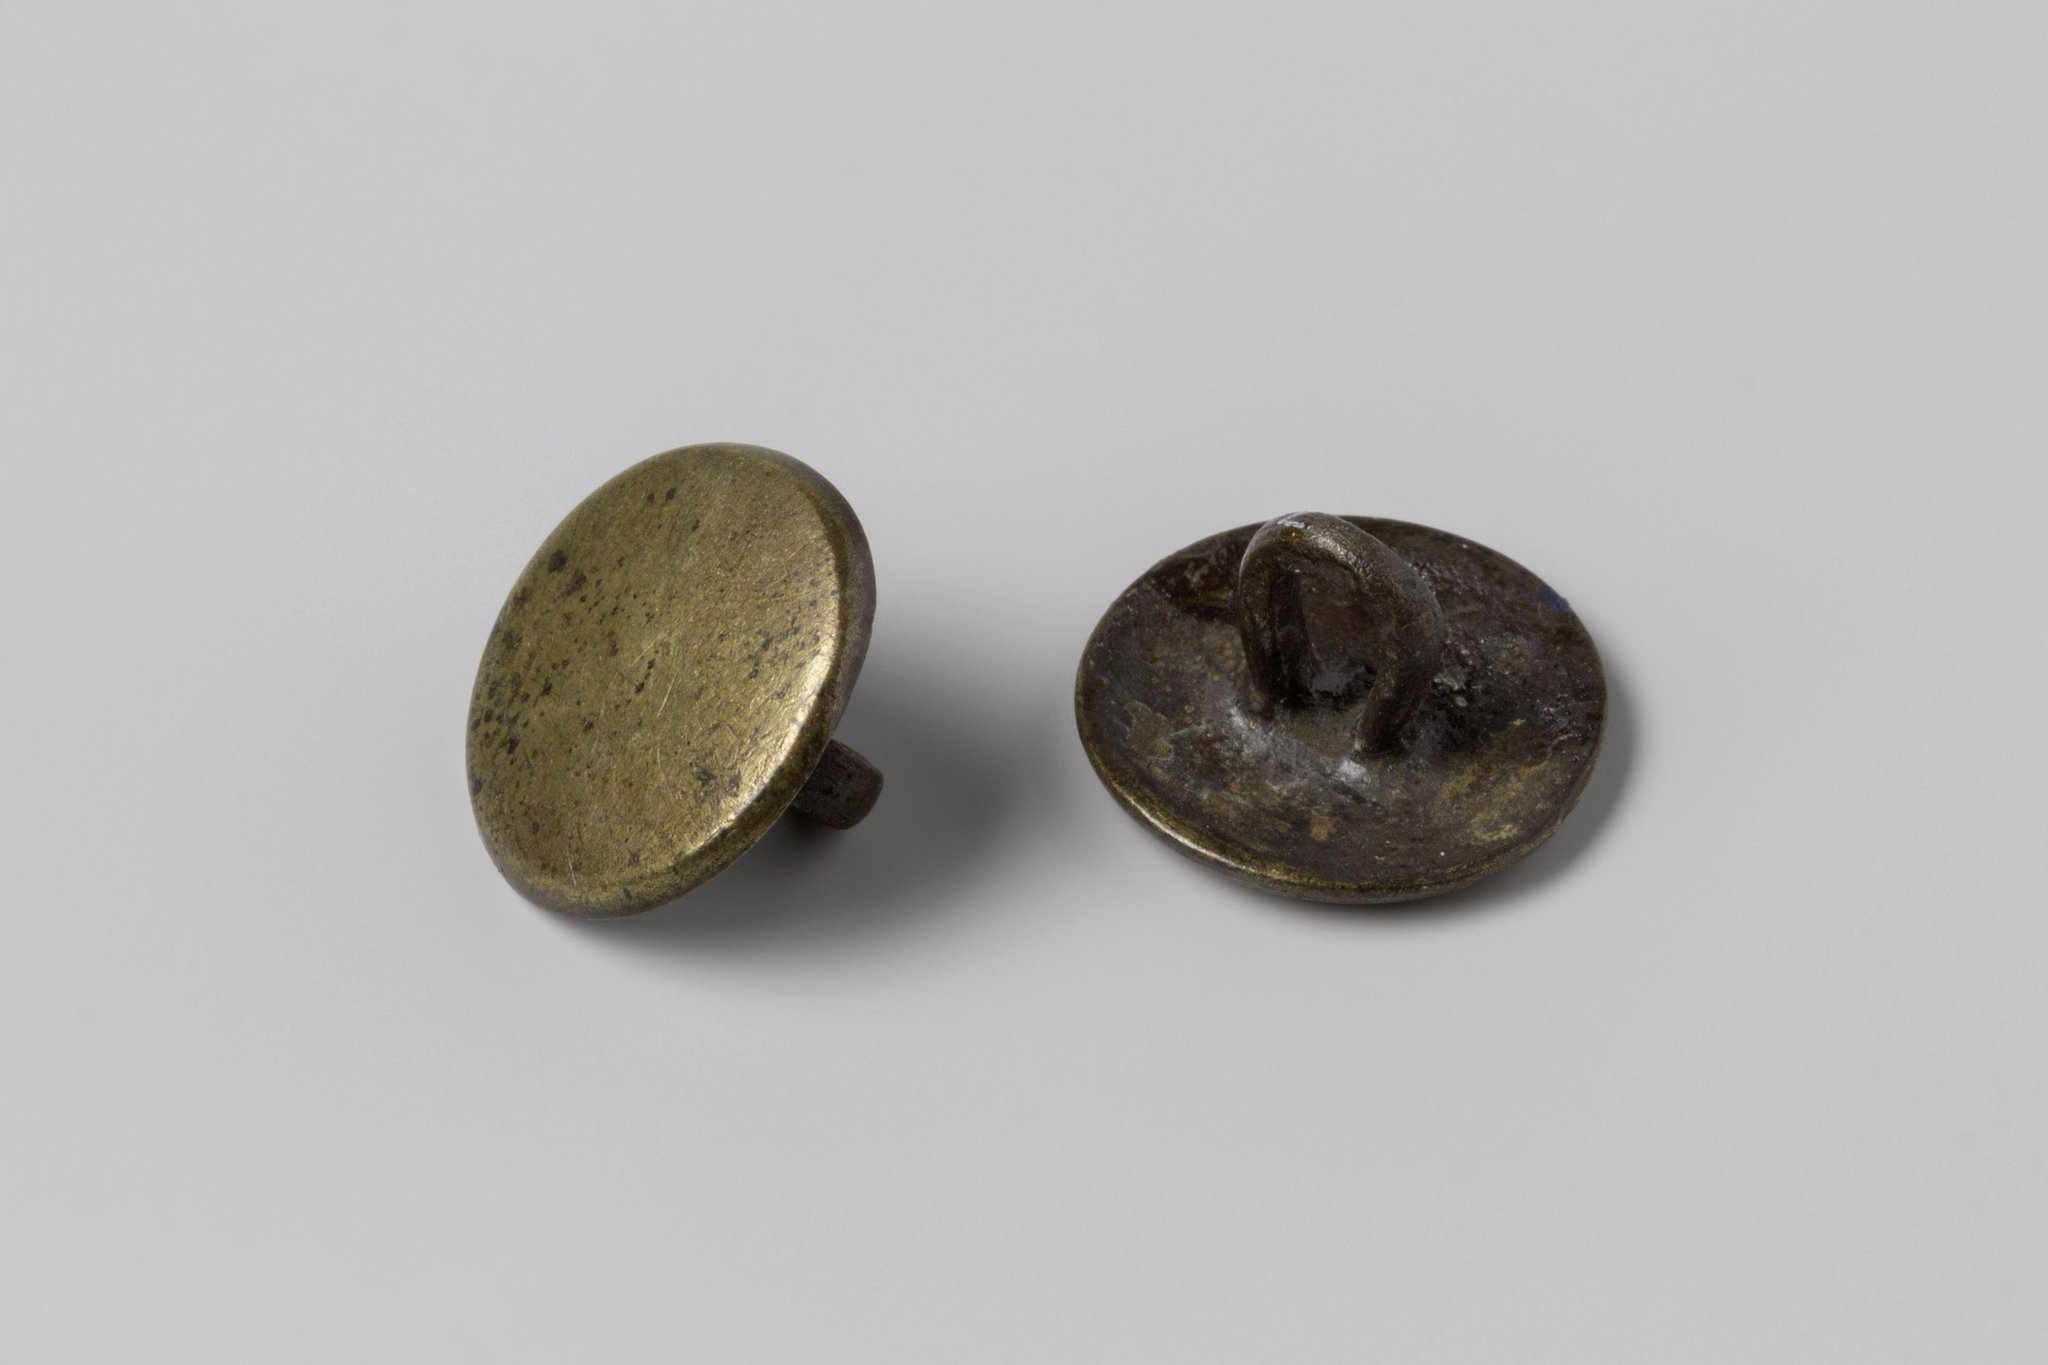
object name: button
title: Twee knopen uit het wrak van de Oost-Indiëvaarder Hollandia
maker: Anonymous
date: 1700-1743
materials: copper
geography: netherlands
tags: verenigde oostindische compagnie, hollandia (schip), annet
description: Twee knopen. (2) flat, plain (1.5d, 0.1t), loop-shank